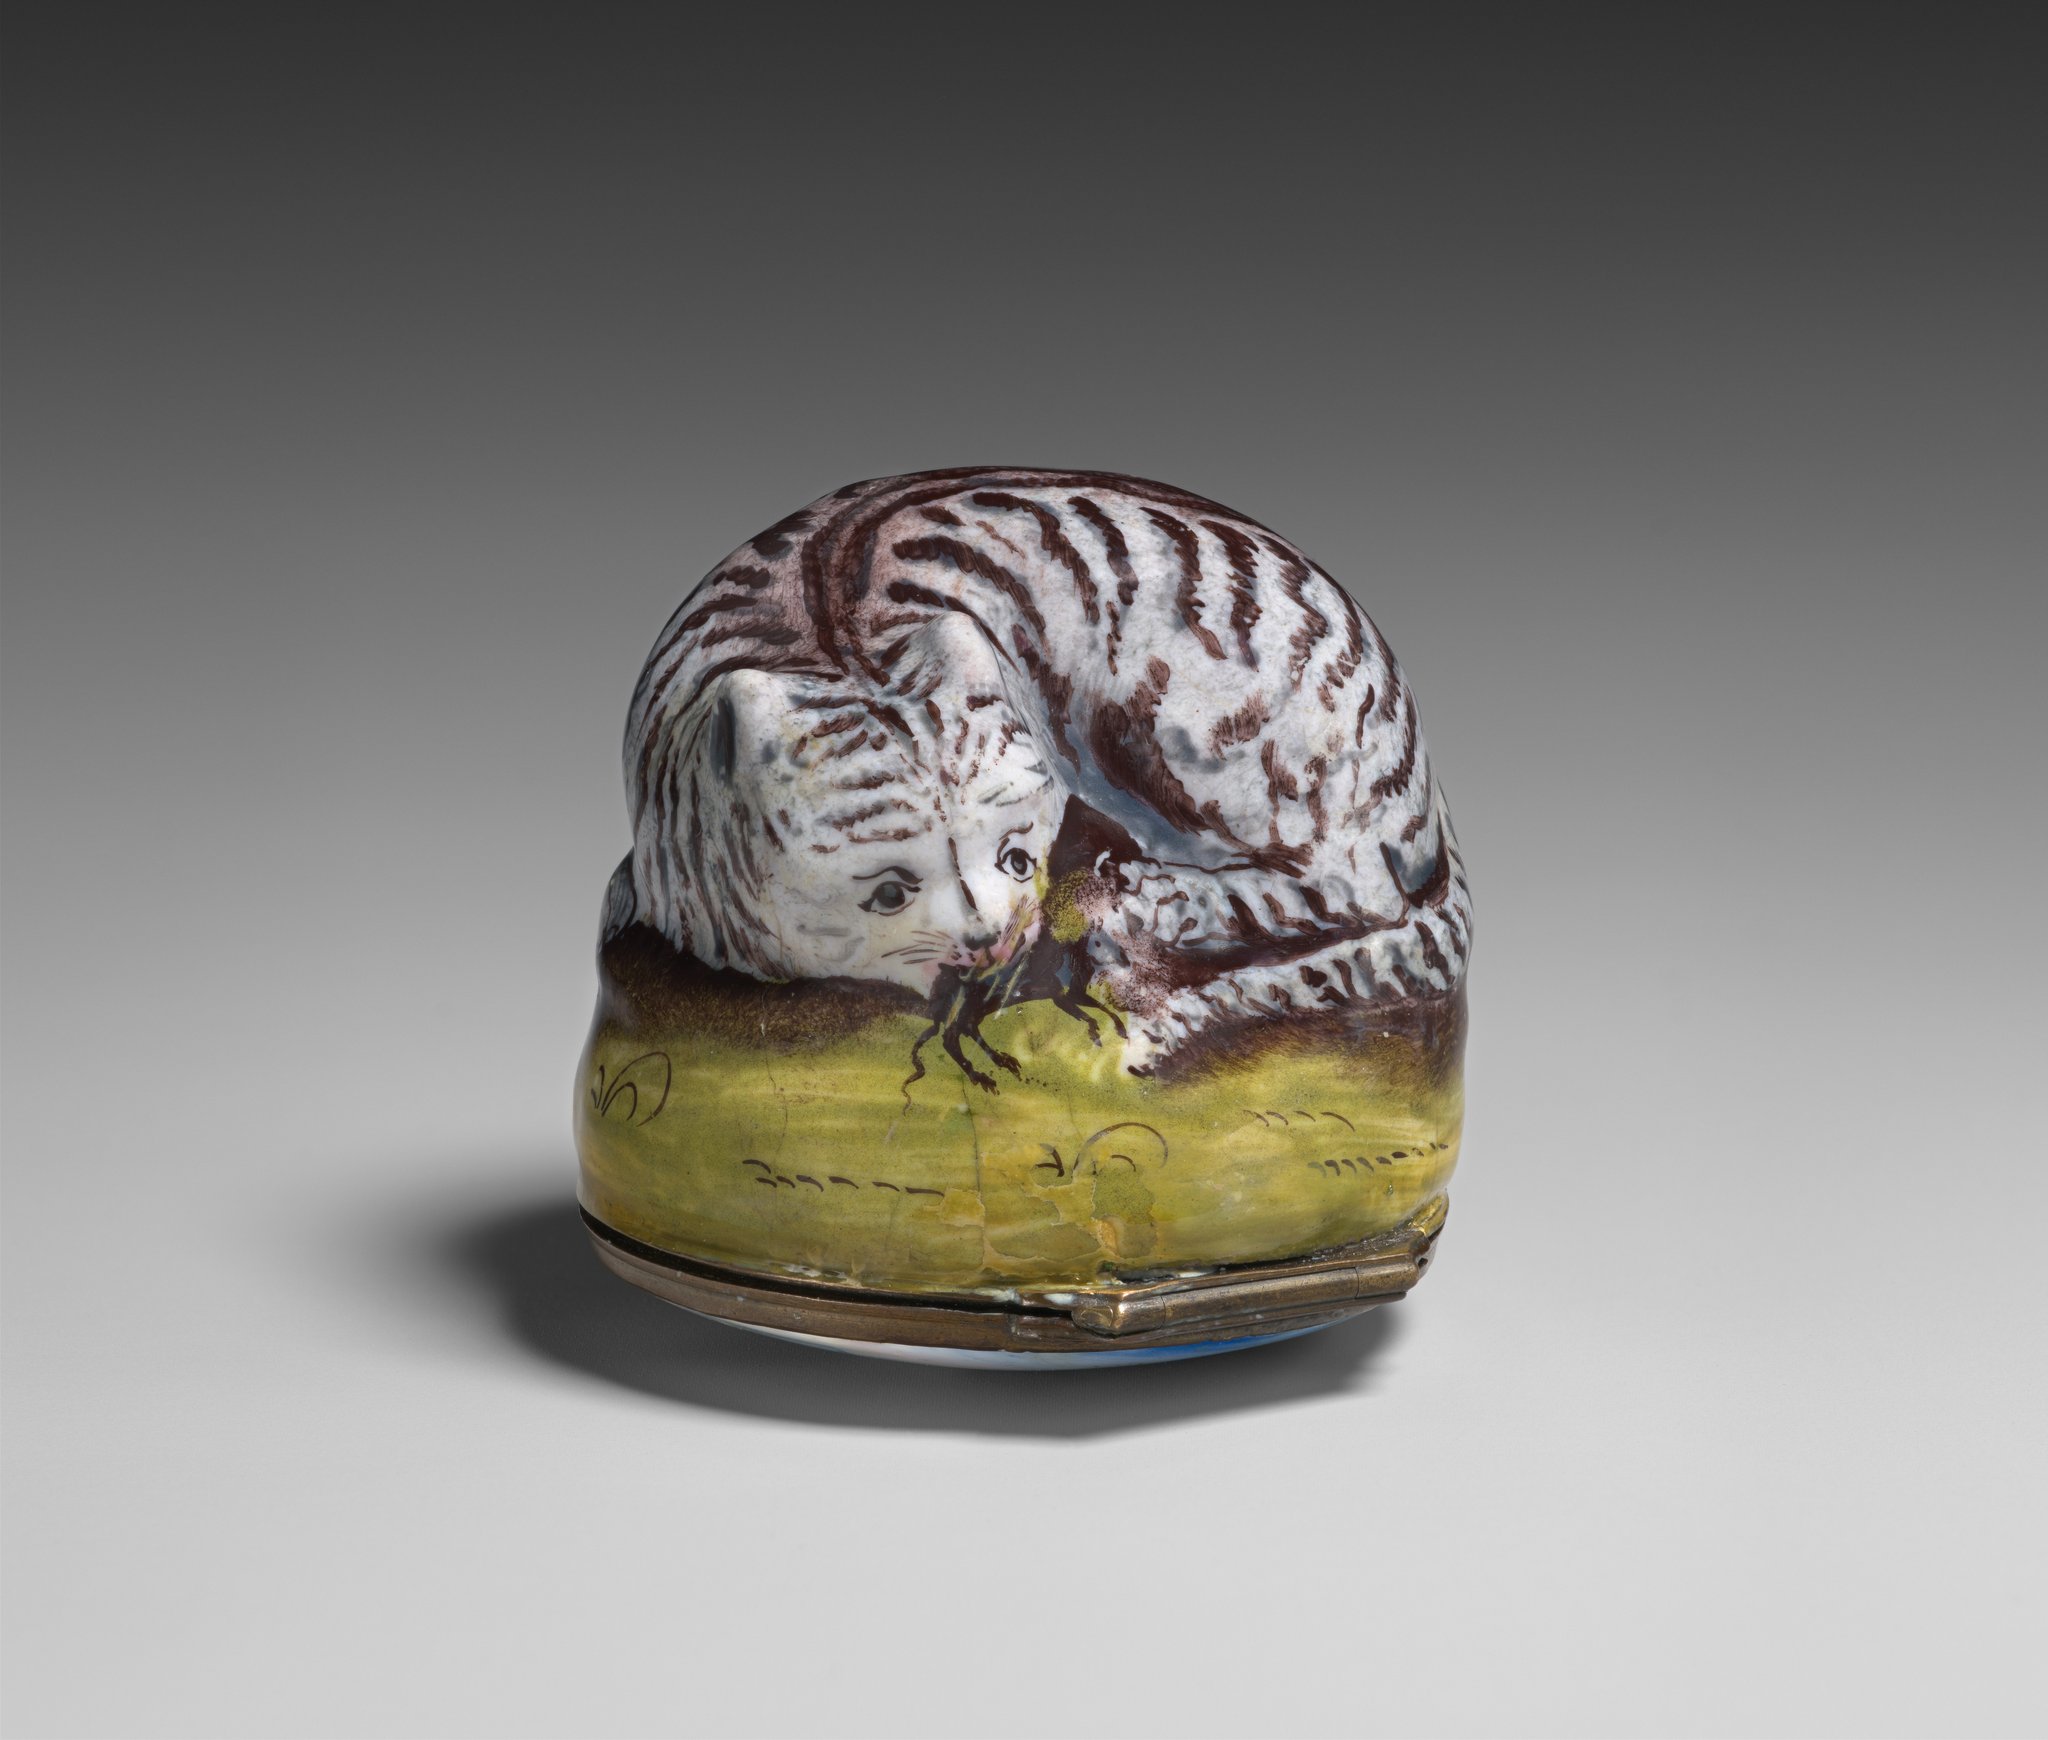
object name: bonbonnière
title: Bonbonnière in the form of a tabby cat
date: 1770-1780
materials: copper, enamel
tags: cats